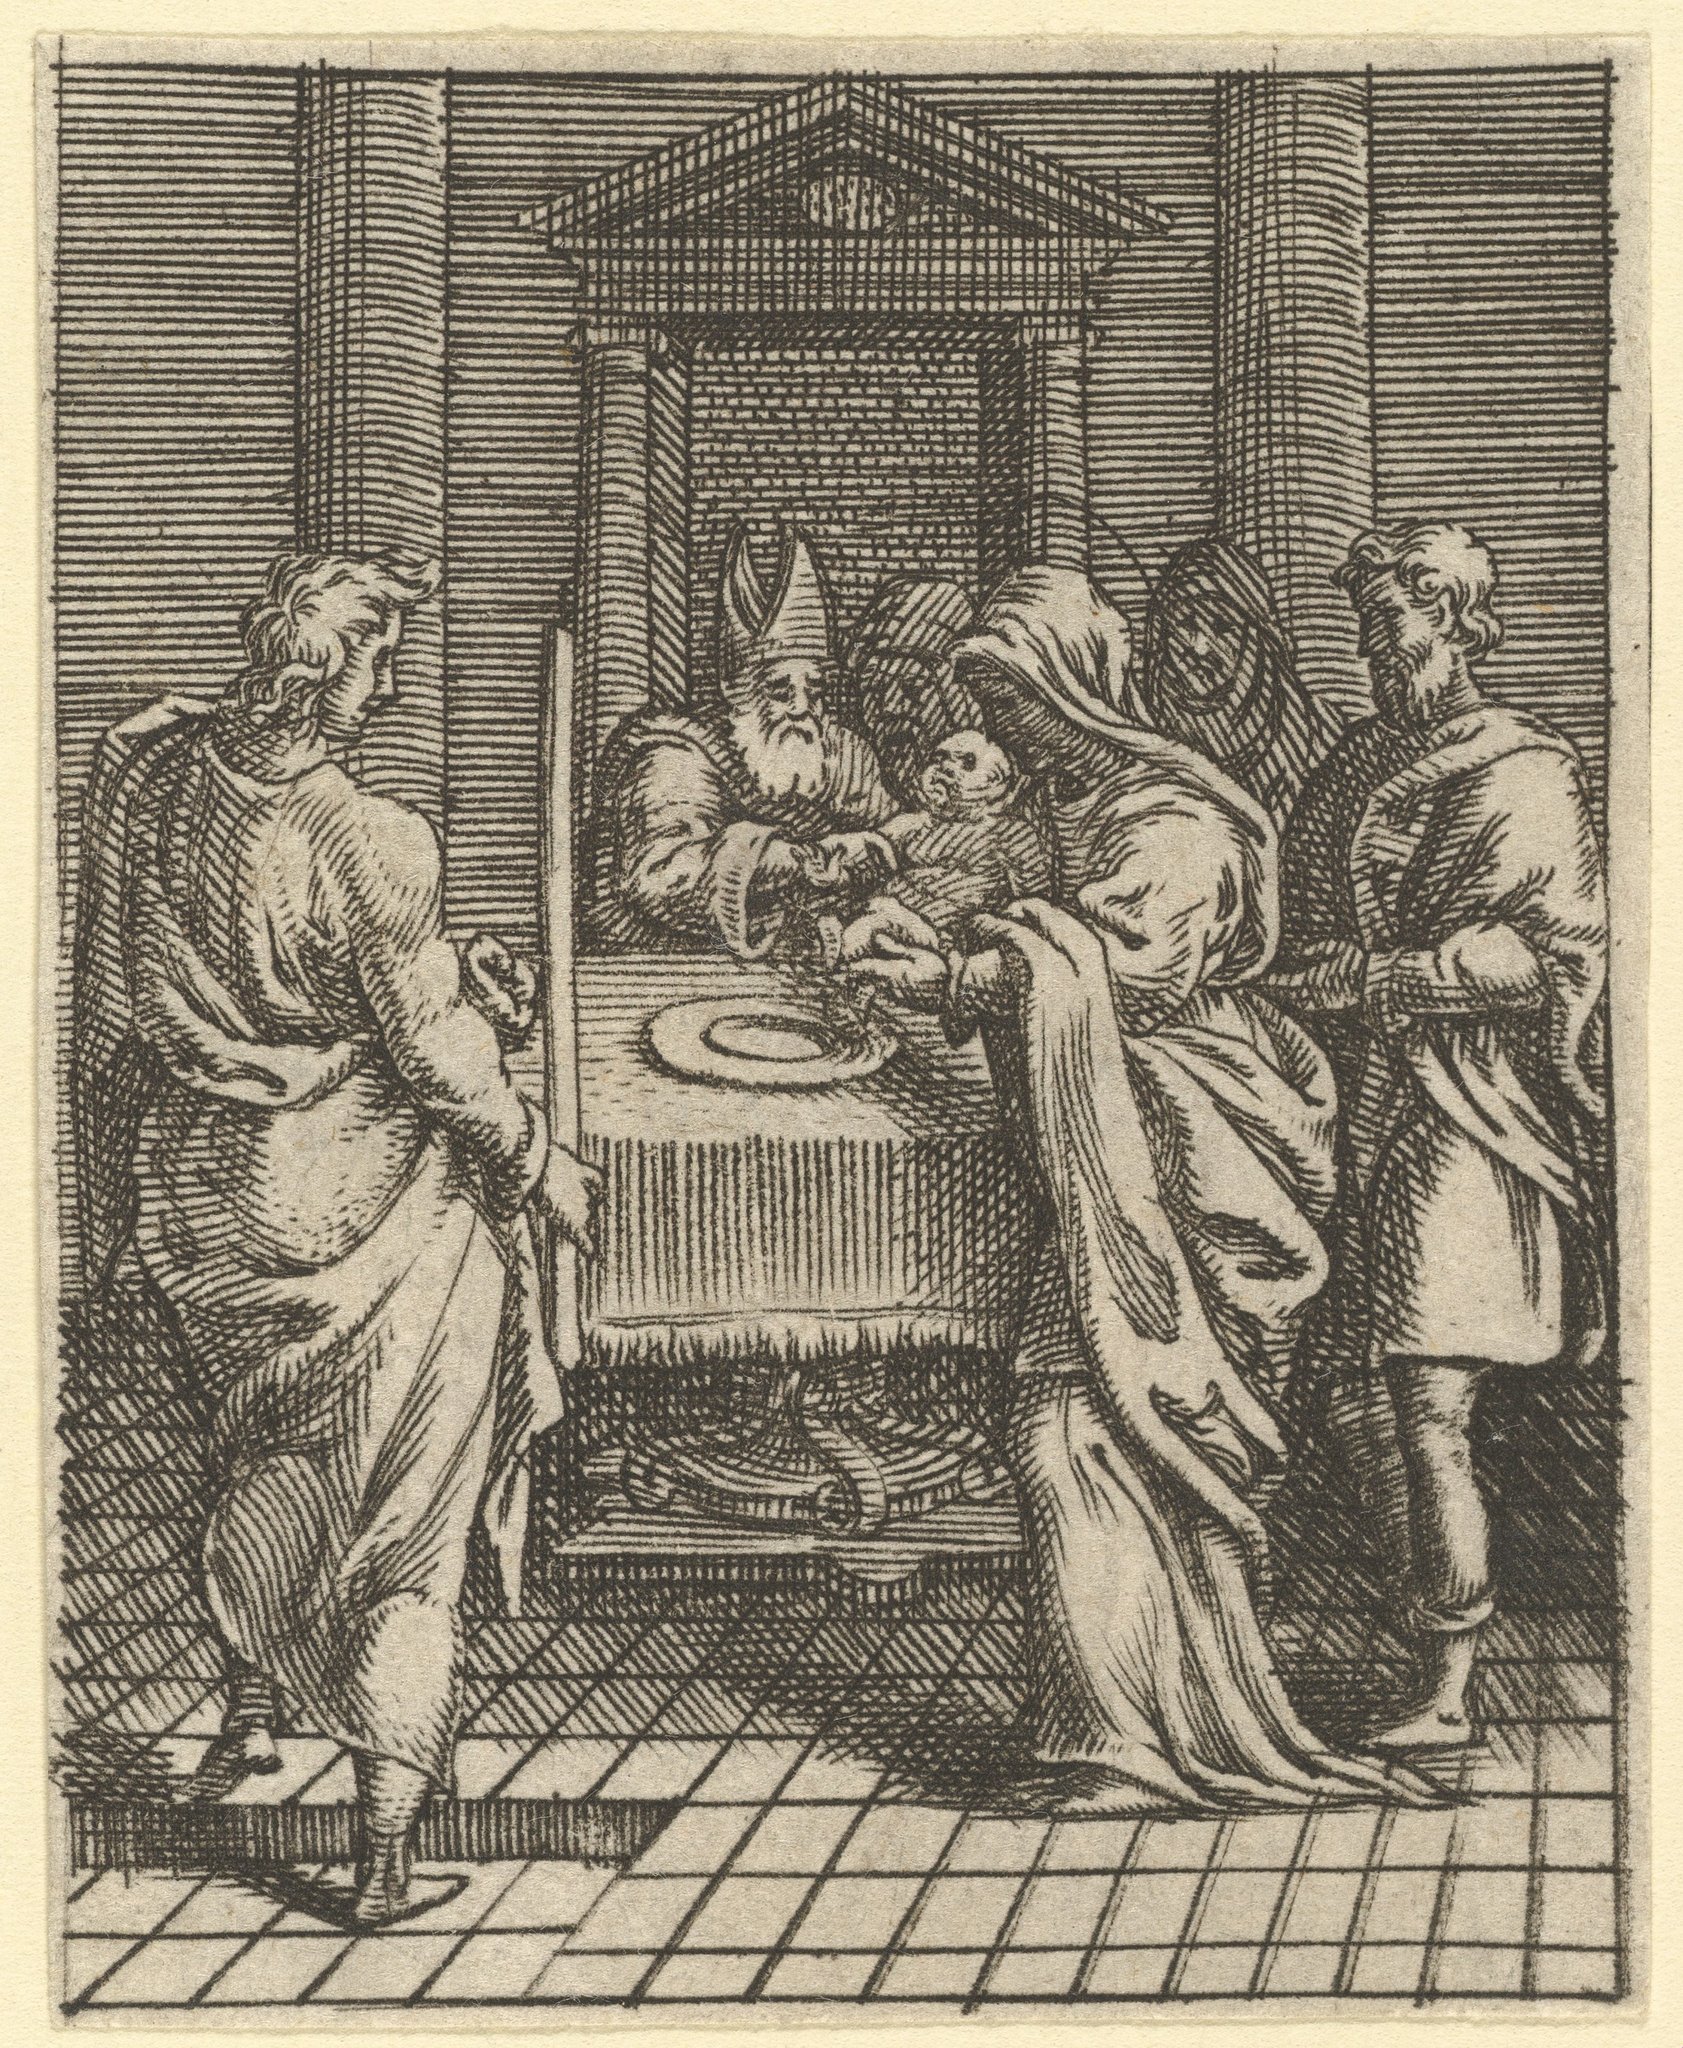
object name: print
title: Virgin of Sorrows: The Presentation in the Temple; one of nine surrounding compartments from the Virgin of Sorrows, now separated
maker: giorgio ghisi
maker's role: artist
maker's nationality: italian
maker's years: 1515-1582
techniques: engraving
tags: infants,men,virgin mary